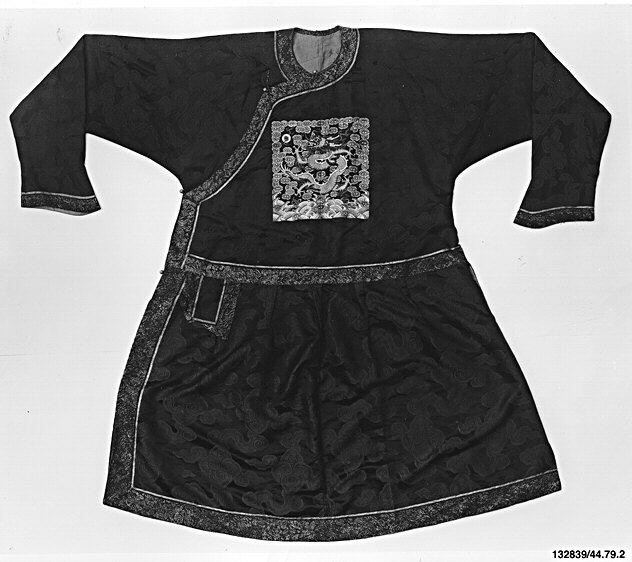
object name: robe of state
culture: chinese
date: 1801-1900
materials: metal thread, silk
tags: dragons